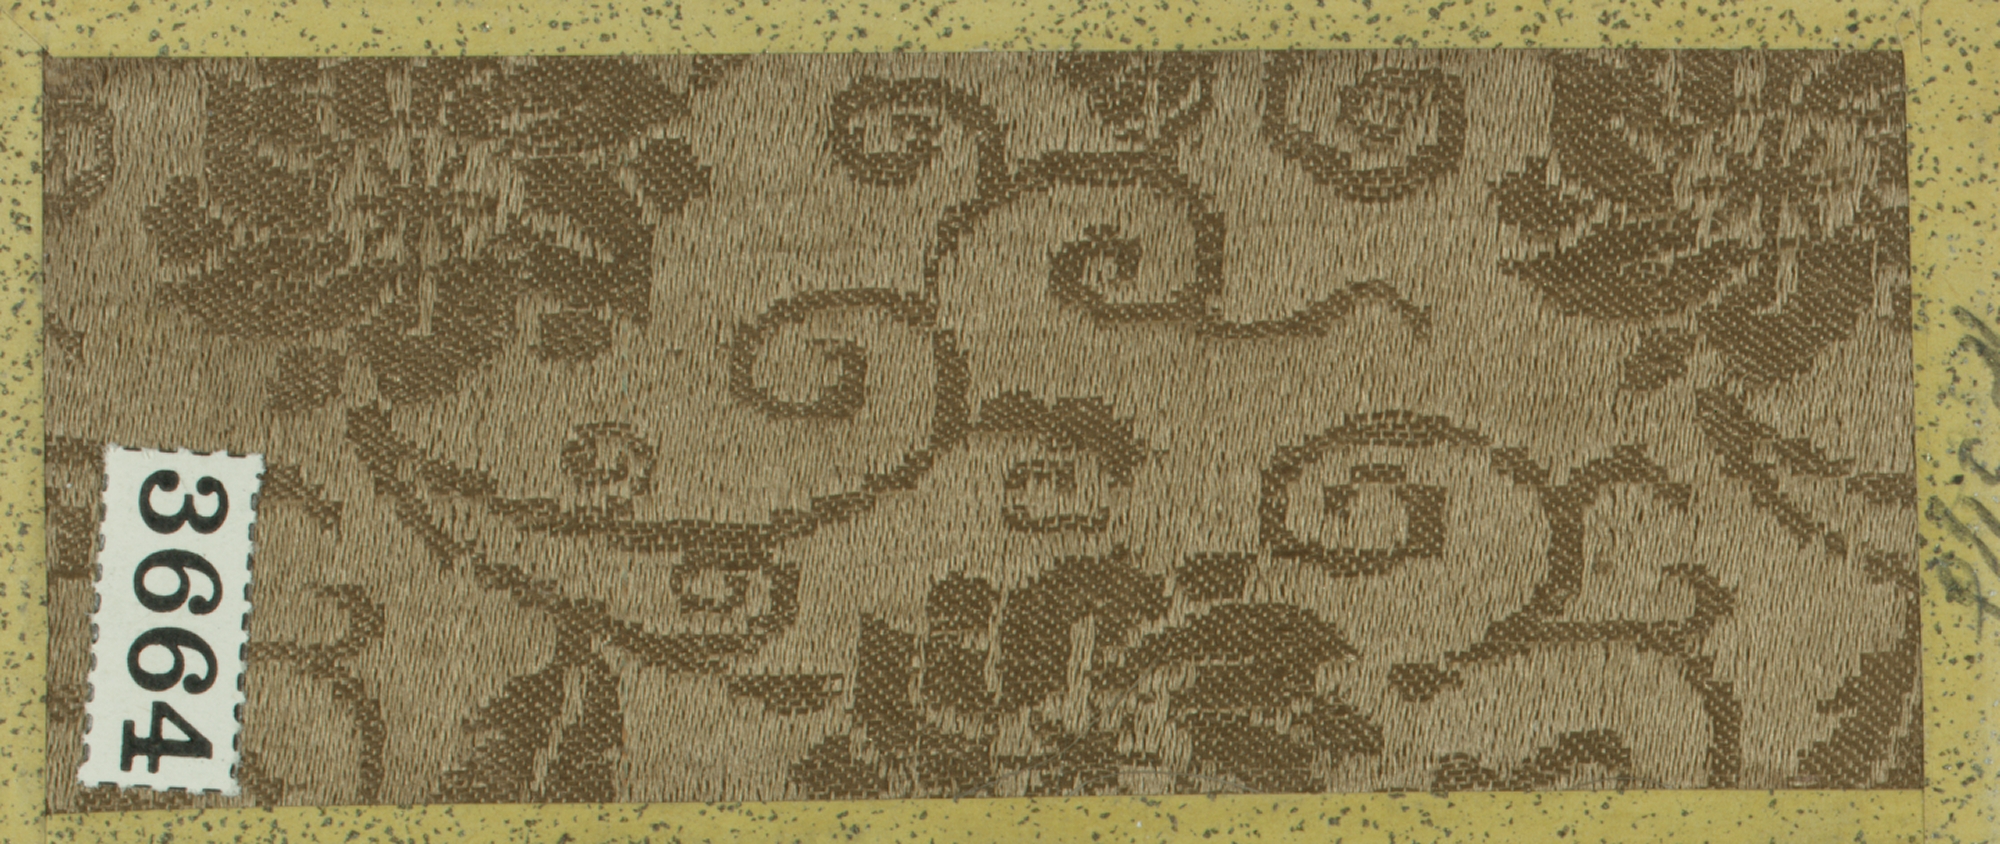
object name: sample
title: Textile Sample from Sample Book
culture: japanese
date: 1801-1900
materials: silk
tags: flowers